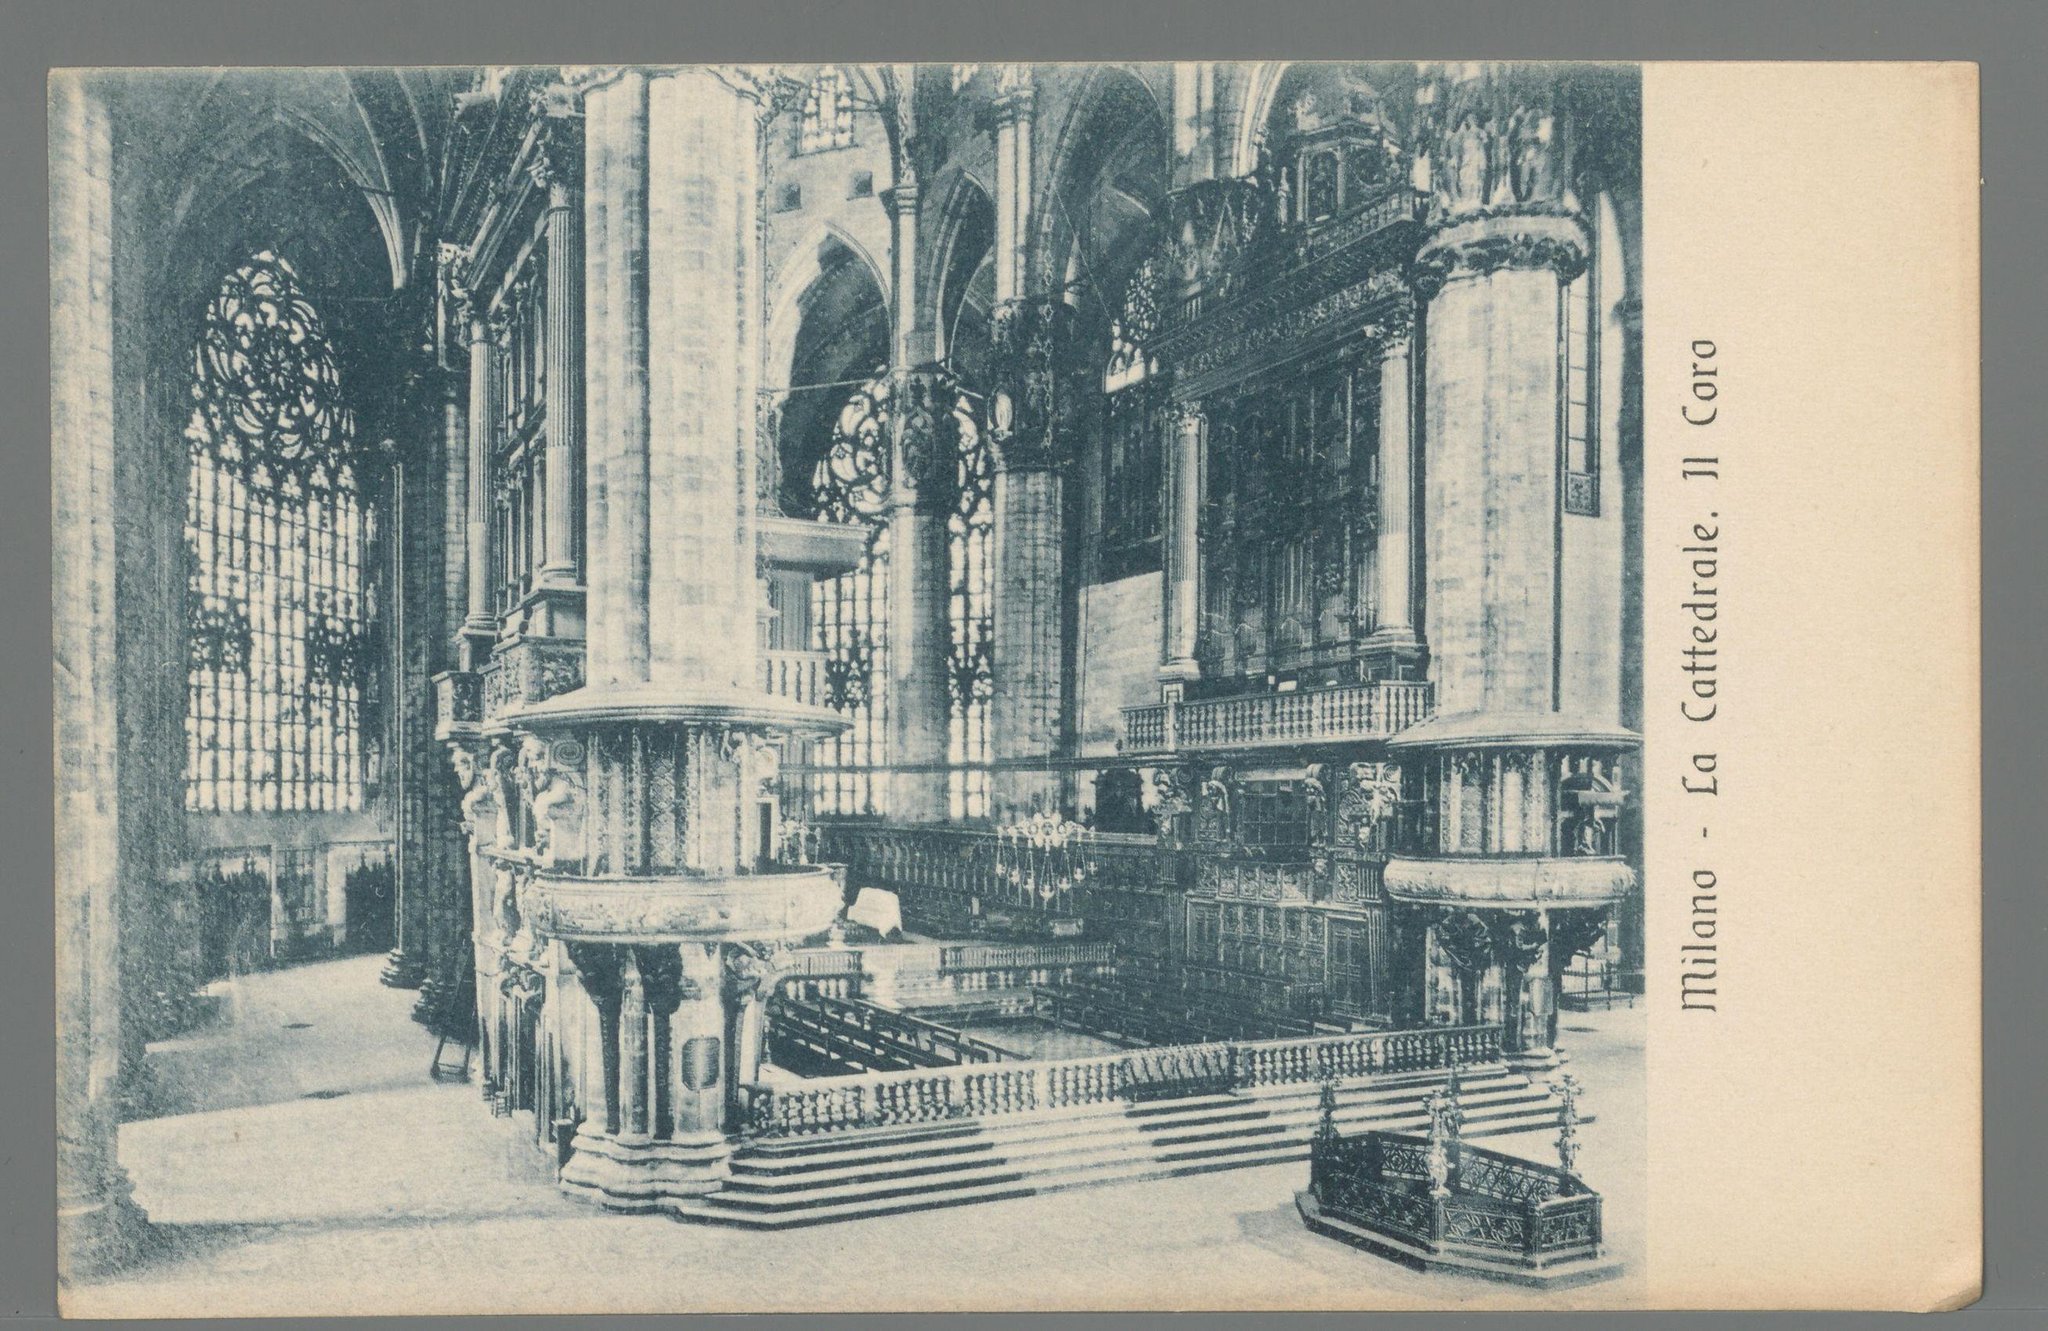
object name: photomechanical print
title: Milano. La Cattedrale. Il Coro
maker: Anonymous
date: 1906-1920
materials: cardboard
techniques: photograph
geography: milan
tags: parts of church interior: choir